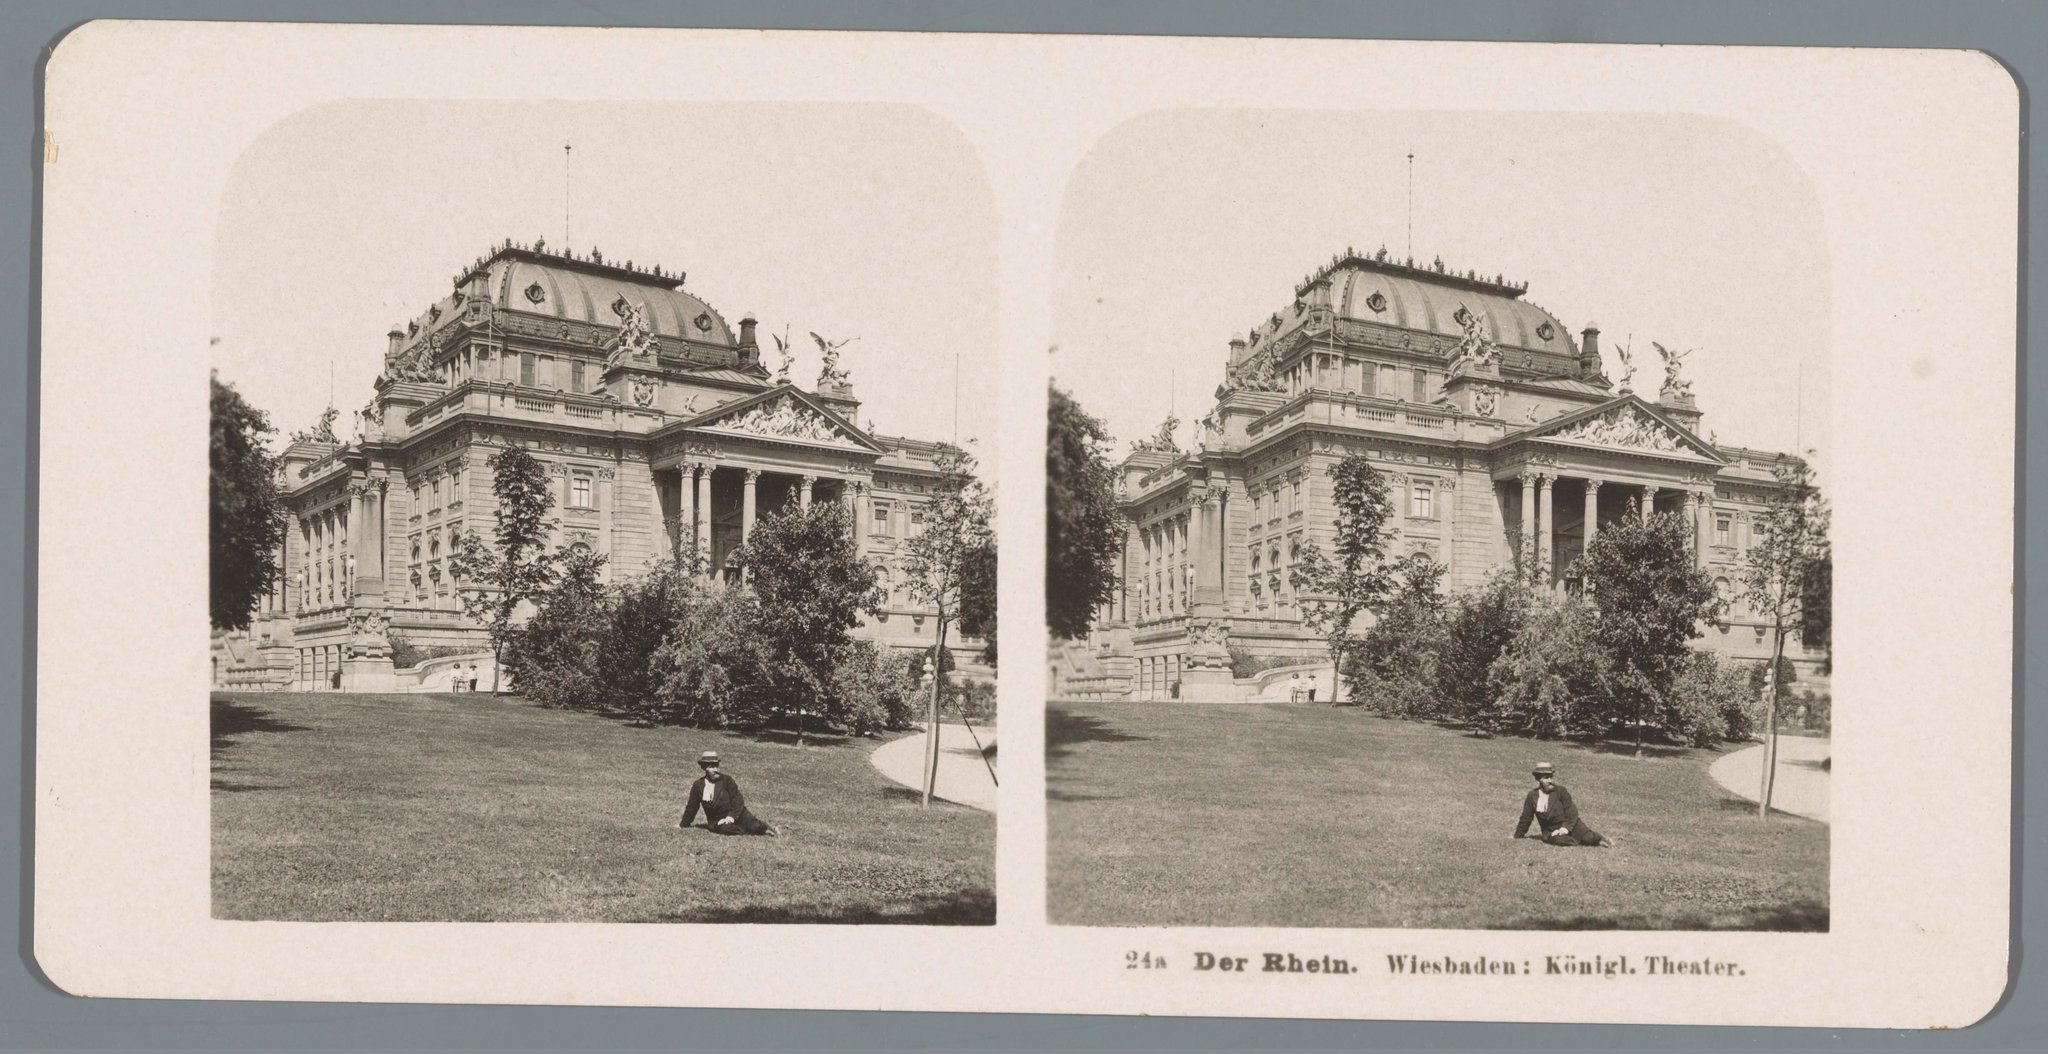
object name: stereograph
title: Der Rhein. Wiesbaden: Königl. Theater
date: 1904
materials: cardboard, photographic support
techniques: gelatin silver print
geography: wiesbaden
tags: theatre (building), façade (of house or building)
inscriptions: number: ‘24a’, inscription: ‘Neue Photographische Gesellschaft A.-G. Steglitz-Berlin 1904.’